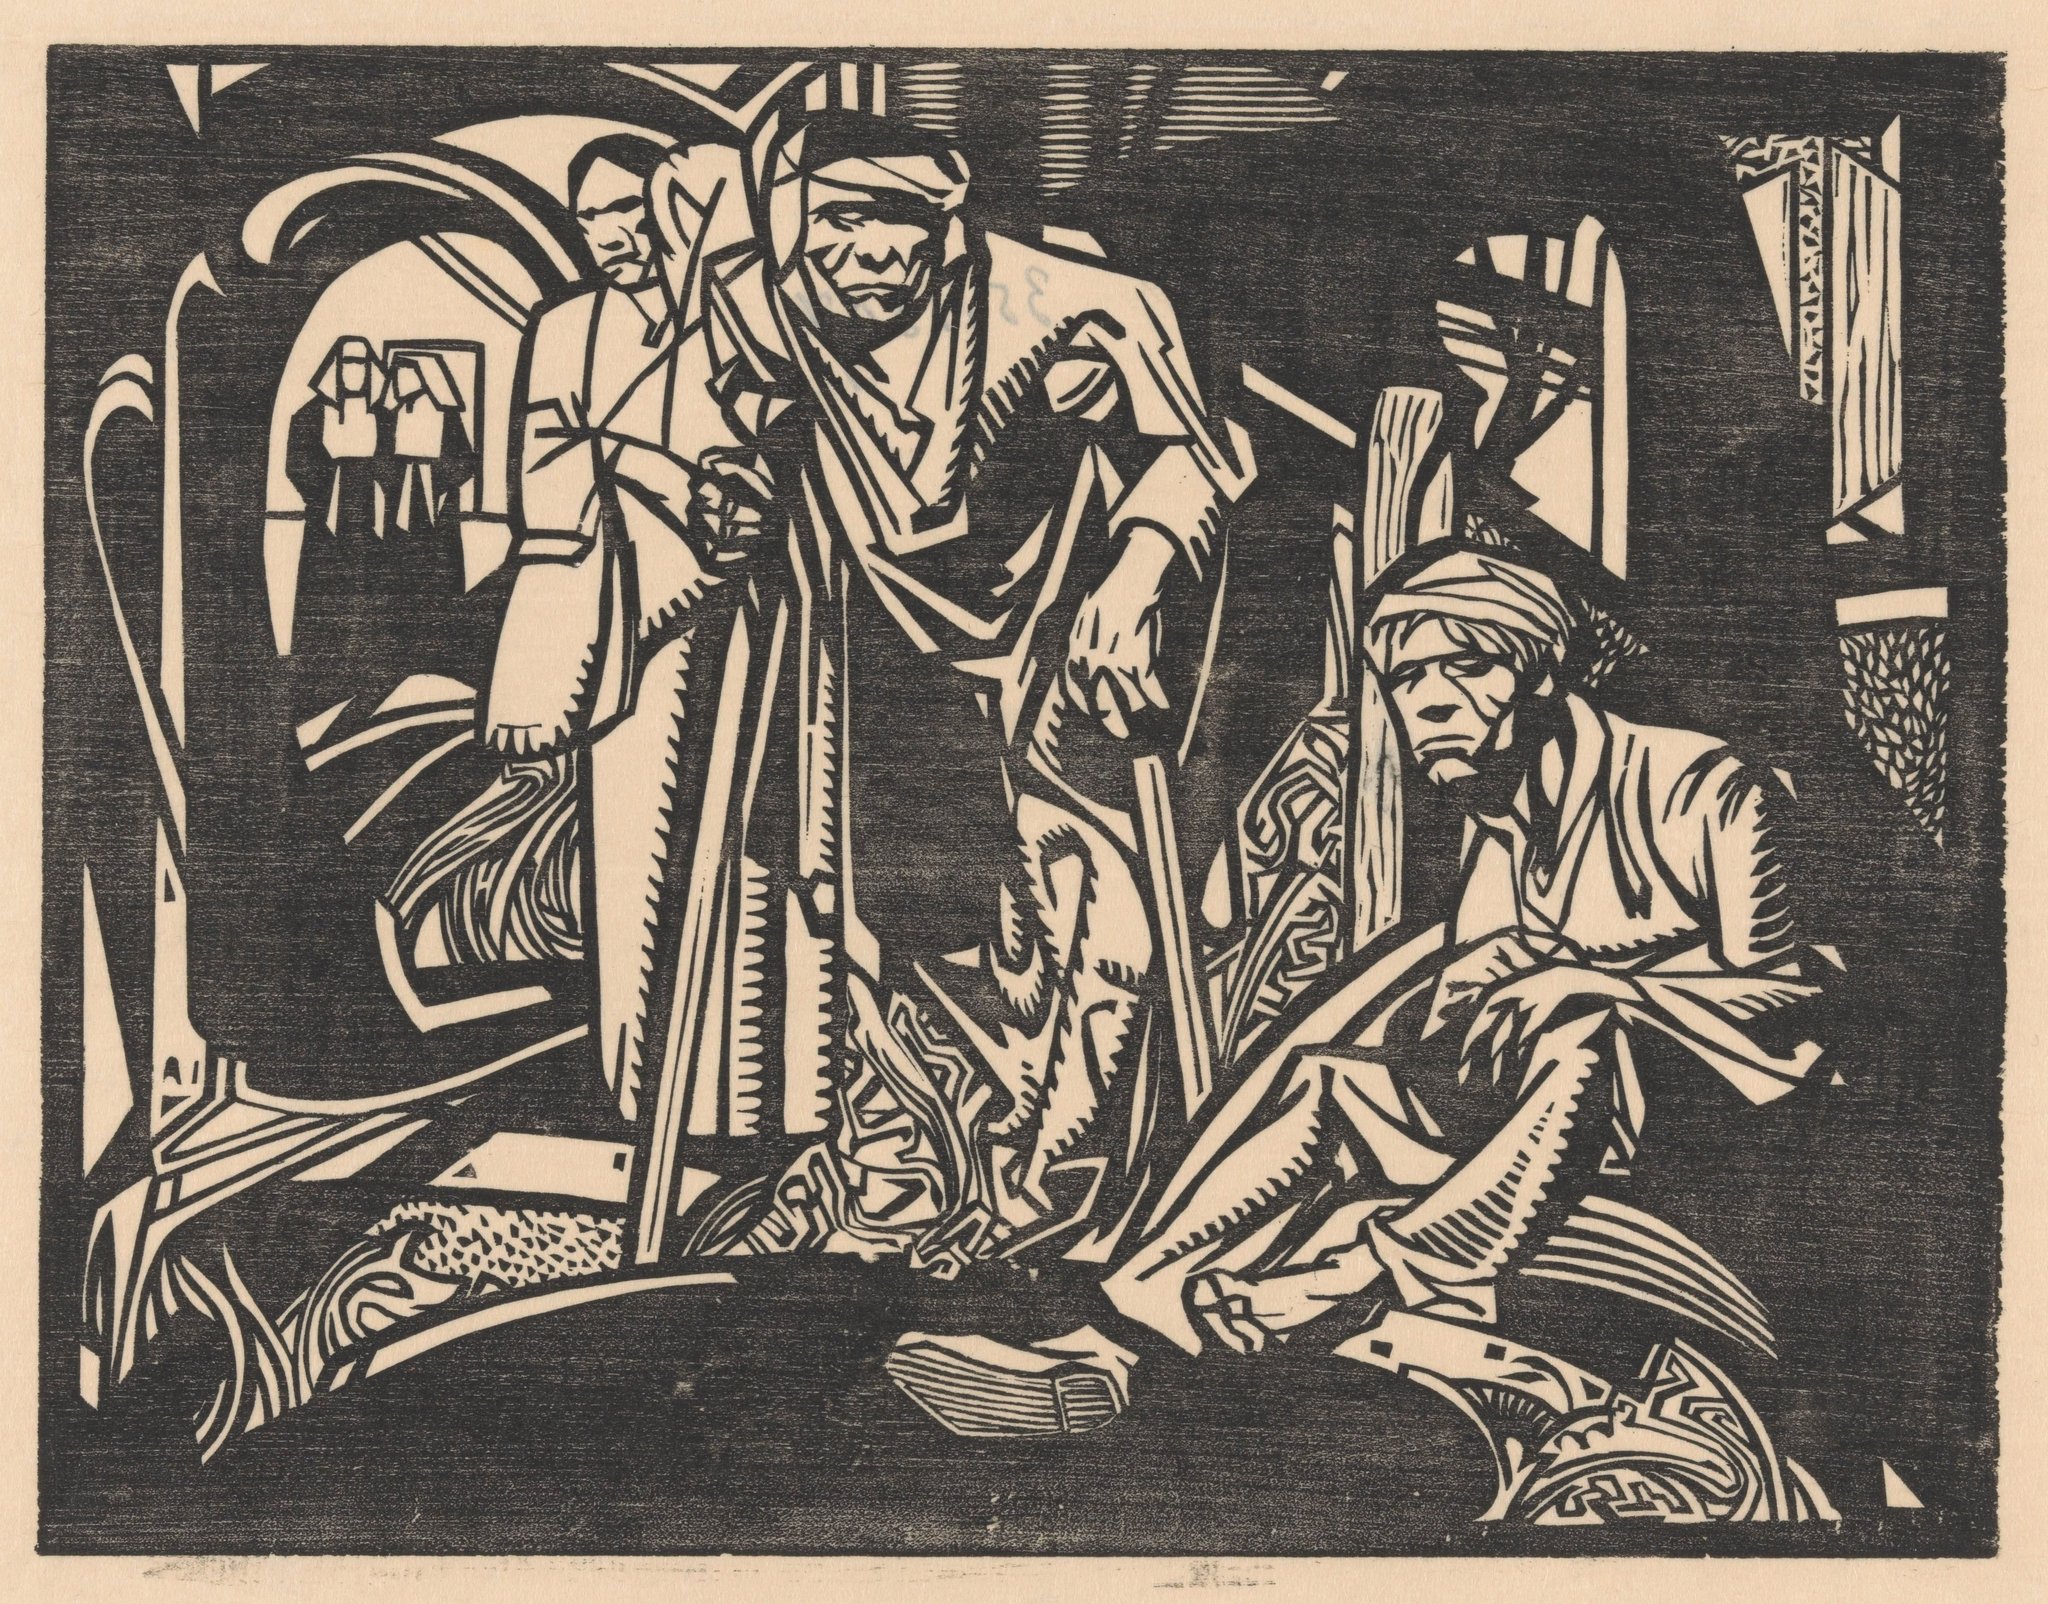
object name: print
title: Gewonden in een kerk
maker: johannes josephus aarts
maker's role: draughtsman, print maker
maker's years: 1871-1934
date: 1881-1934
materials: paper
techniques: woodcut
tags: crutches, nun(s), patient, sick person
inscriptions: collector's mark: Lugt 2166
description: Een man leunt op twee krukken. Rechts van hem zit een man met opgetrokken rechterbeen. Links op de achtergrond twee nonnen in habijt.